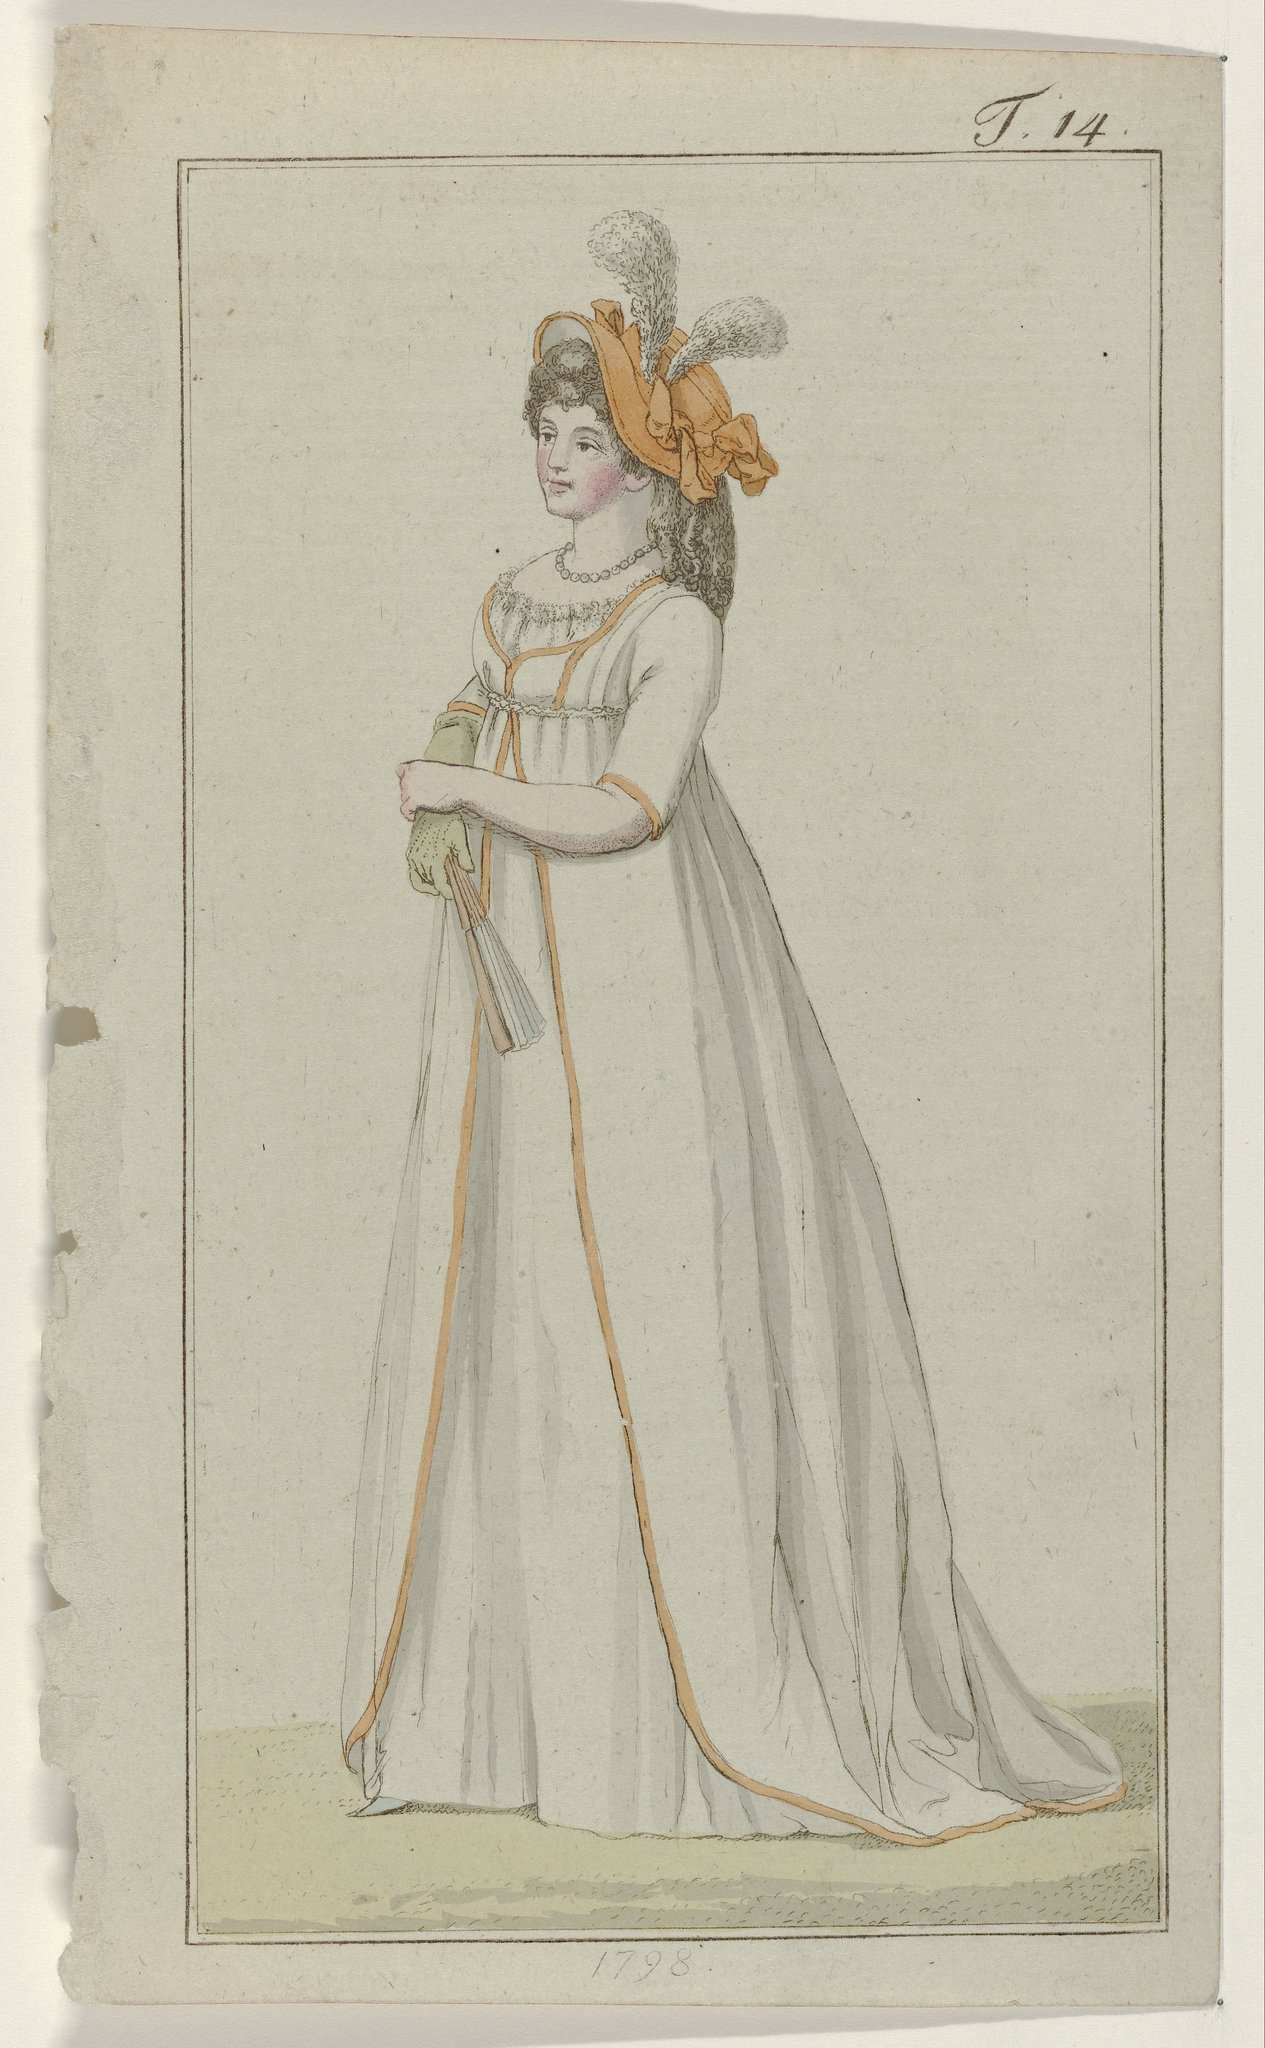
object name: fashion print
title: Journal des Luxus und der Moden, 1798, T 14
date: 1798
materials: paper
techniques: etching, hand coloring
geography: weimar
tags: head-gear (+ women's clothes), fashion plates, shoes, sandals (+ women's clothes), gloves, mittens, etc. (+ women's clothes), dress, gown (+ women's clothes), fan (+ women's clothes), necklace (+ women's clothes), belt, girdle, waistband (+ women's clothes)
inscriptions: date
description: Staande vrouw gekleed in een openvallende japon met halflange mouwen en sleepje, afgezet met een bies in contrasterende kleur. Op een onderjapon(?). Zij draagt aan de rechterhand een lange handschoen. Verdere accessoires: hoed met veren, collier, ceintuur, waaier. Prent uit het modetijdschrift Journal des Luxus und der Moden, uitgegeven door Friedrich Justin Bertuch en Georg Melchior Kraus, Weimar, 1786-1826.